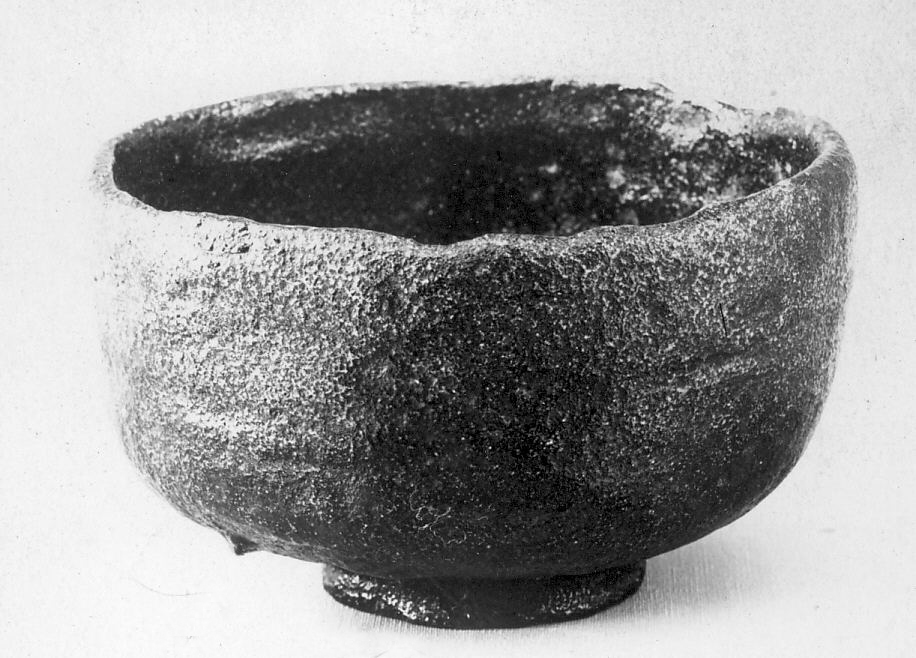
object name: teabowl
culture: japanese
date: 1601-1700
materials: clay, glaze